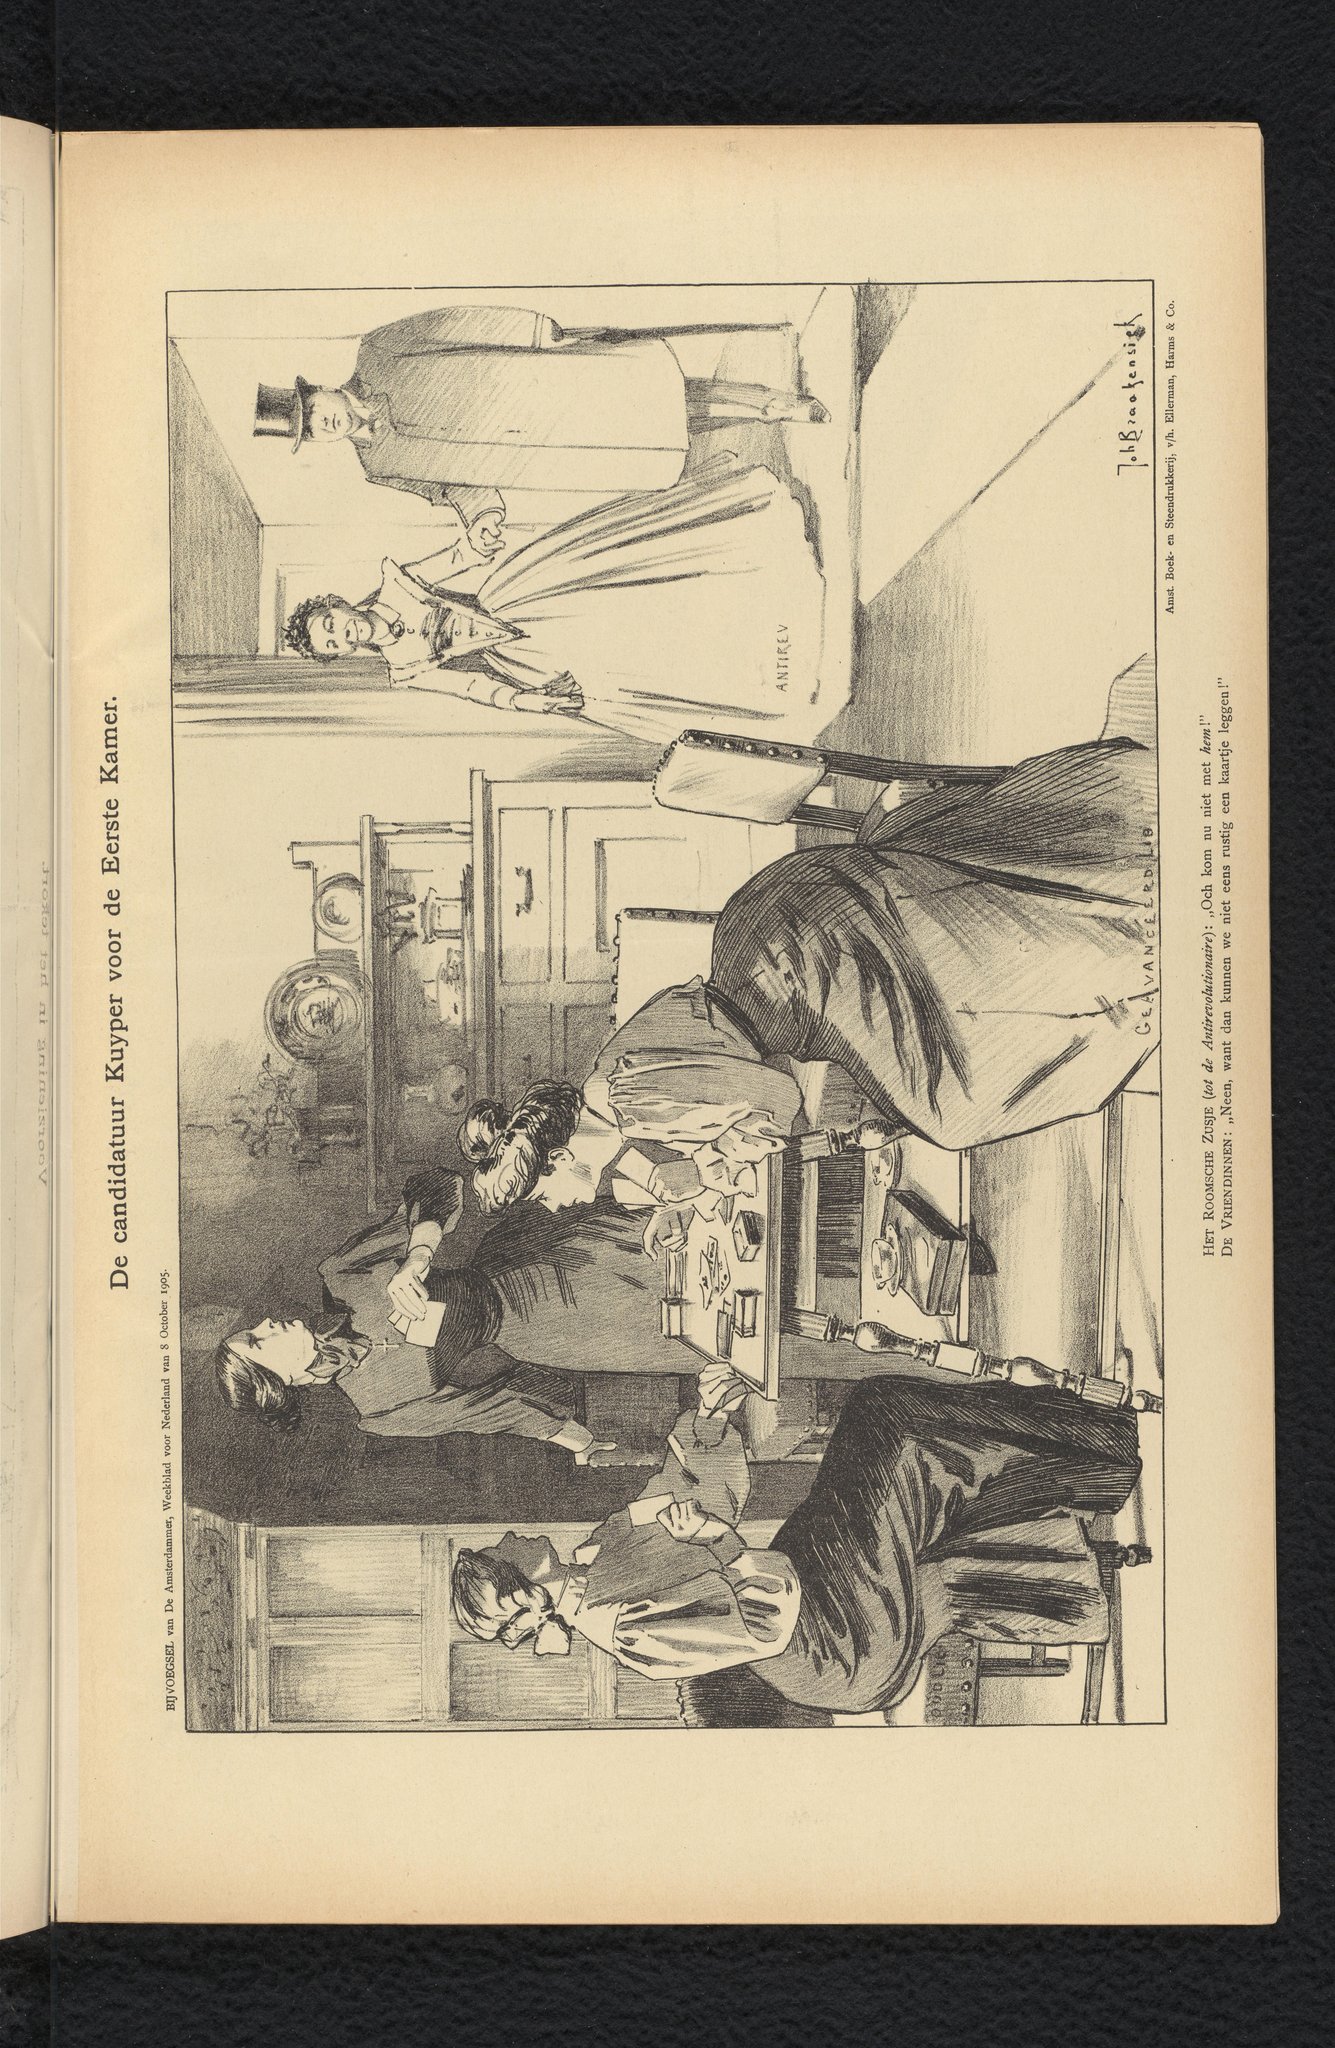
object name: cartoon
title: De candidatuur Kuyper voor de Eerste Kamer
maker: johan braakensiek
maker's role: draughtsman, print maker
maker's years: 1858-1940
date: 1905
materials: paper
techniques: lithograph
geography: netherlands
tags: the hague, abraham kuyper, playing-cards, upper house, senate, political caricatures and satires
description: Het oudere zusje, de Anti-Revolutionaire Partij, in de Eerste Kamer brengt Abraham Kuyper mee om te spelen in het kaartclubje met drie andere vrouwen, politieke partijen in de Eerste kamer.